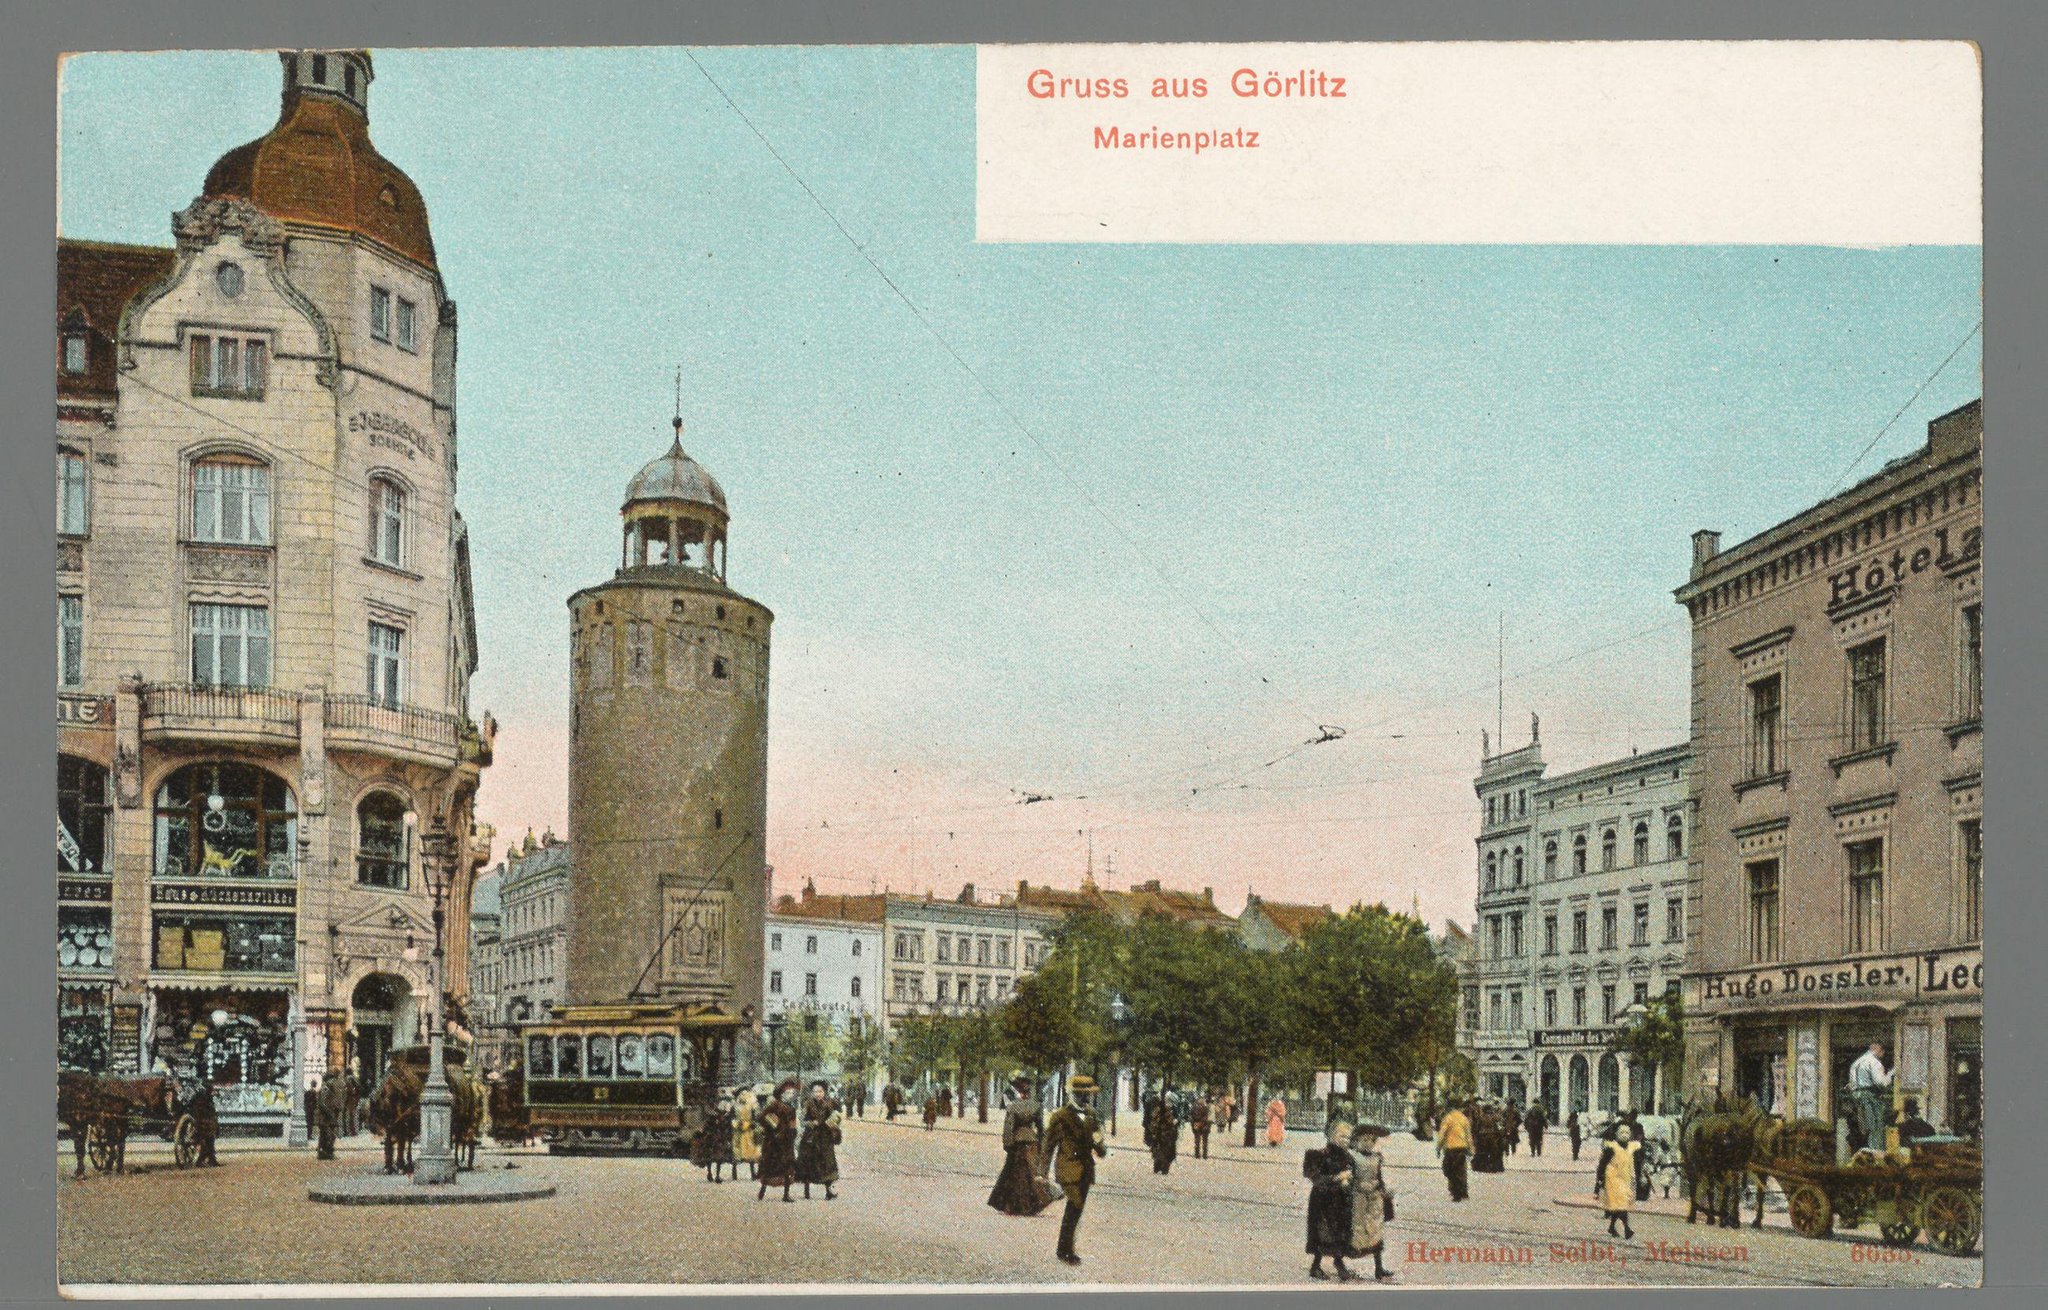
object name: ansichtkaart, prentbriefkaart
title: Gruss aus Görlitz. Marienplatz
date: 1885-1905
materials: cardboard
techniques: lithograph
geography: meissen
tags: square, place, circus, etc., street